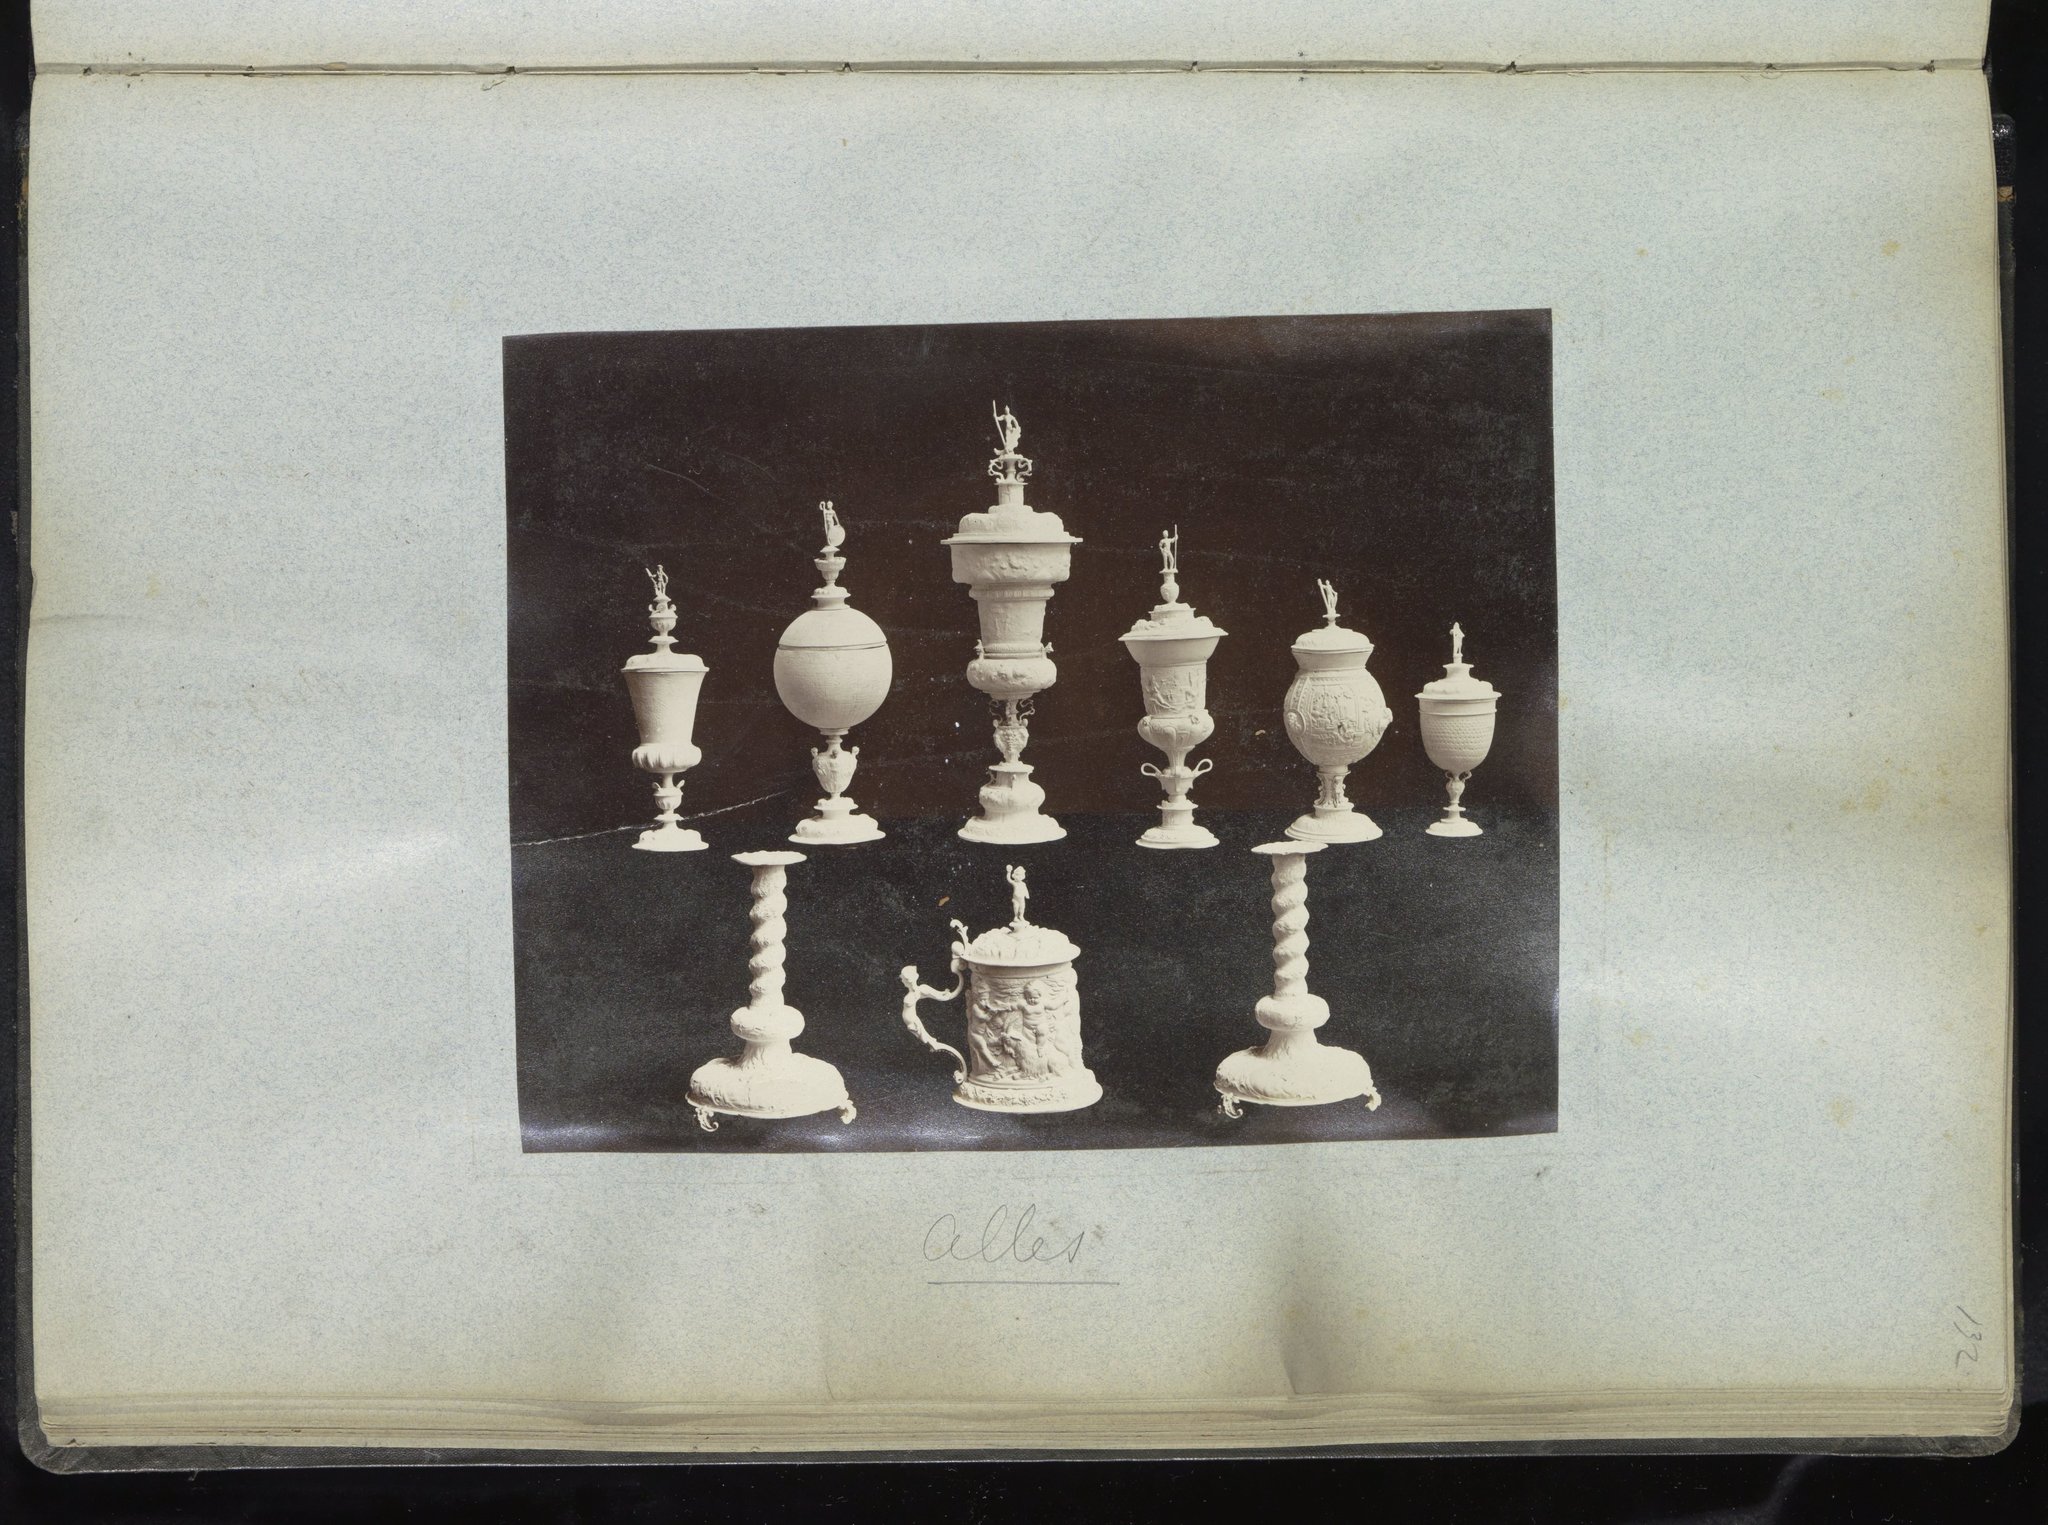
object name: album leaf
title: Negen gipsen afgietsels van onder meer urnen en kandelaars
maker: Anonymous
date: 1875-1900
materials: paper, photographic support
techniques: albumen print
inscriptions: annotation: ‘Alles’